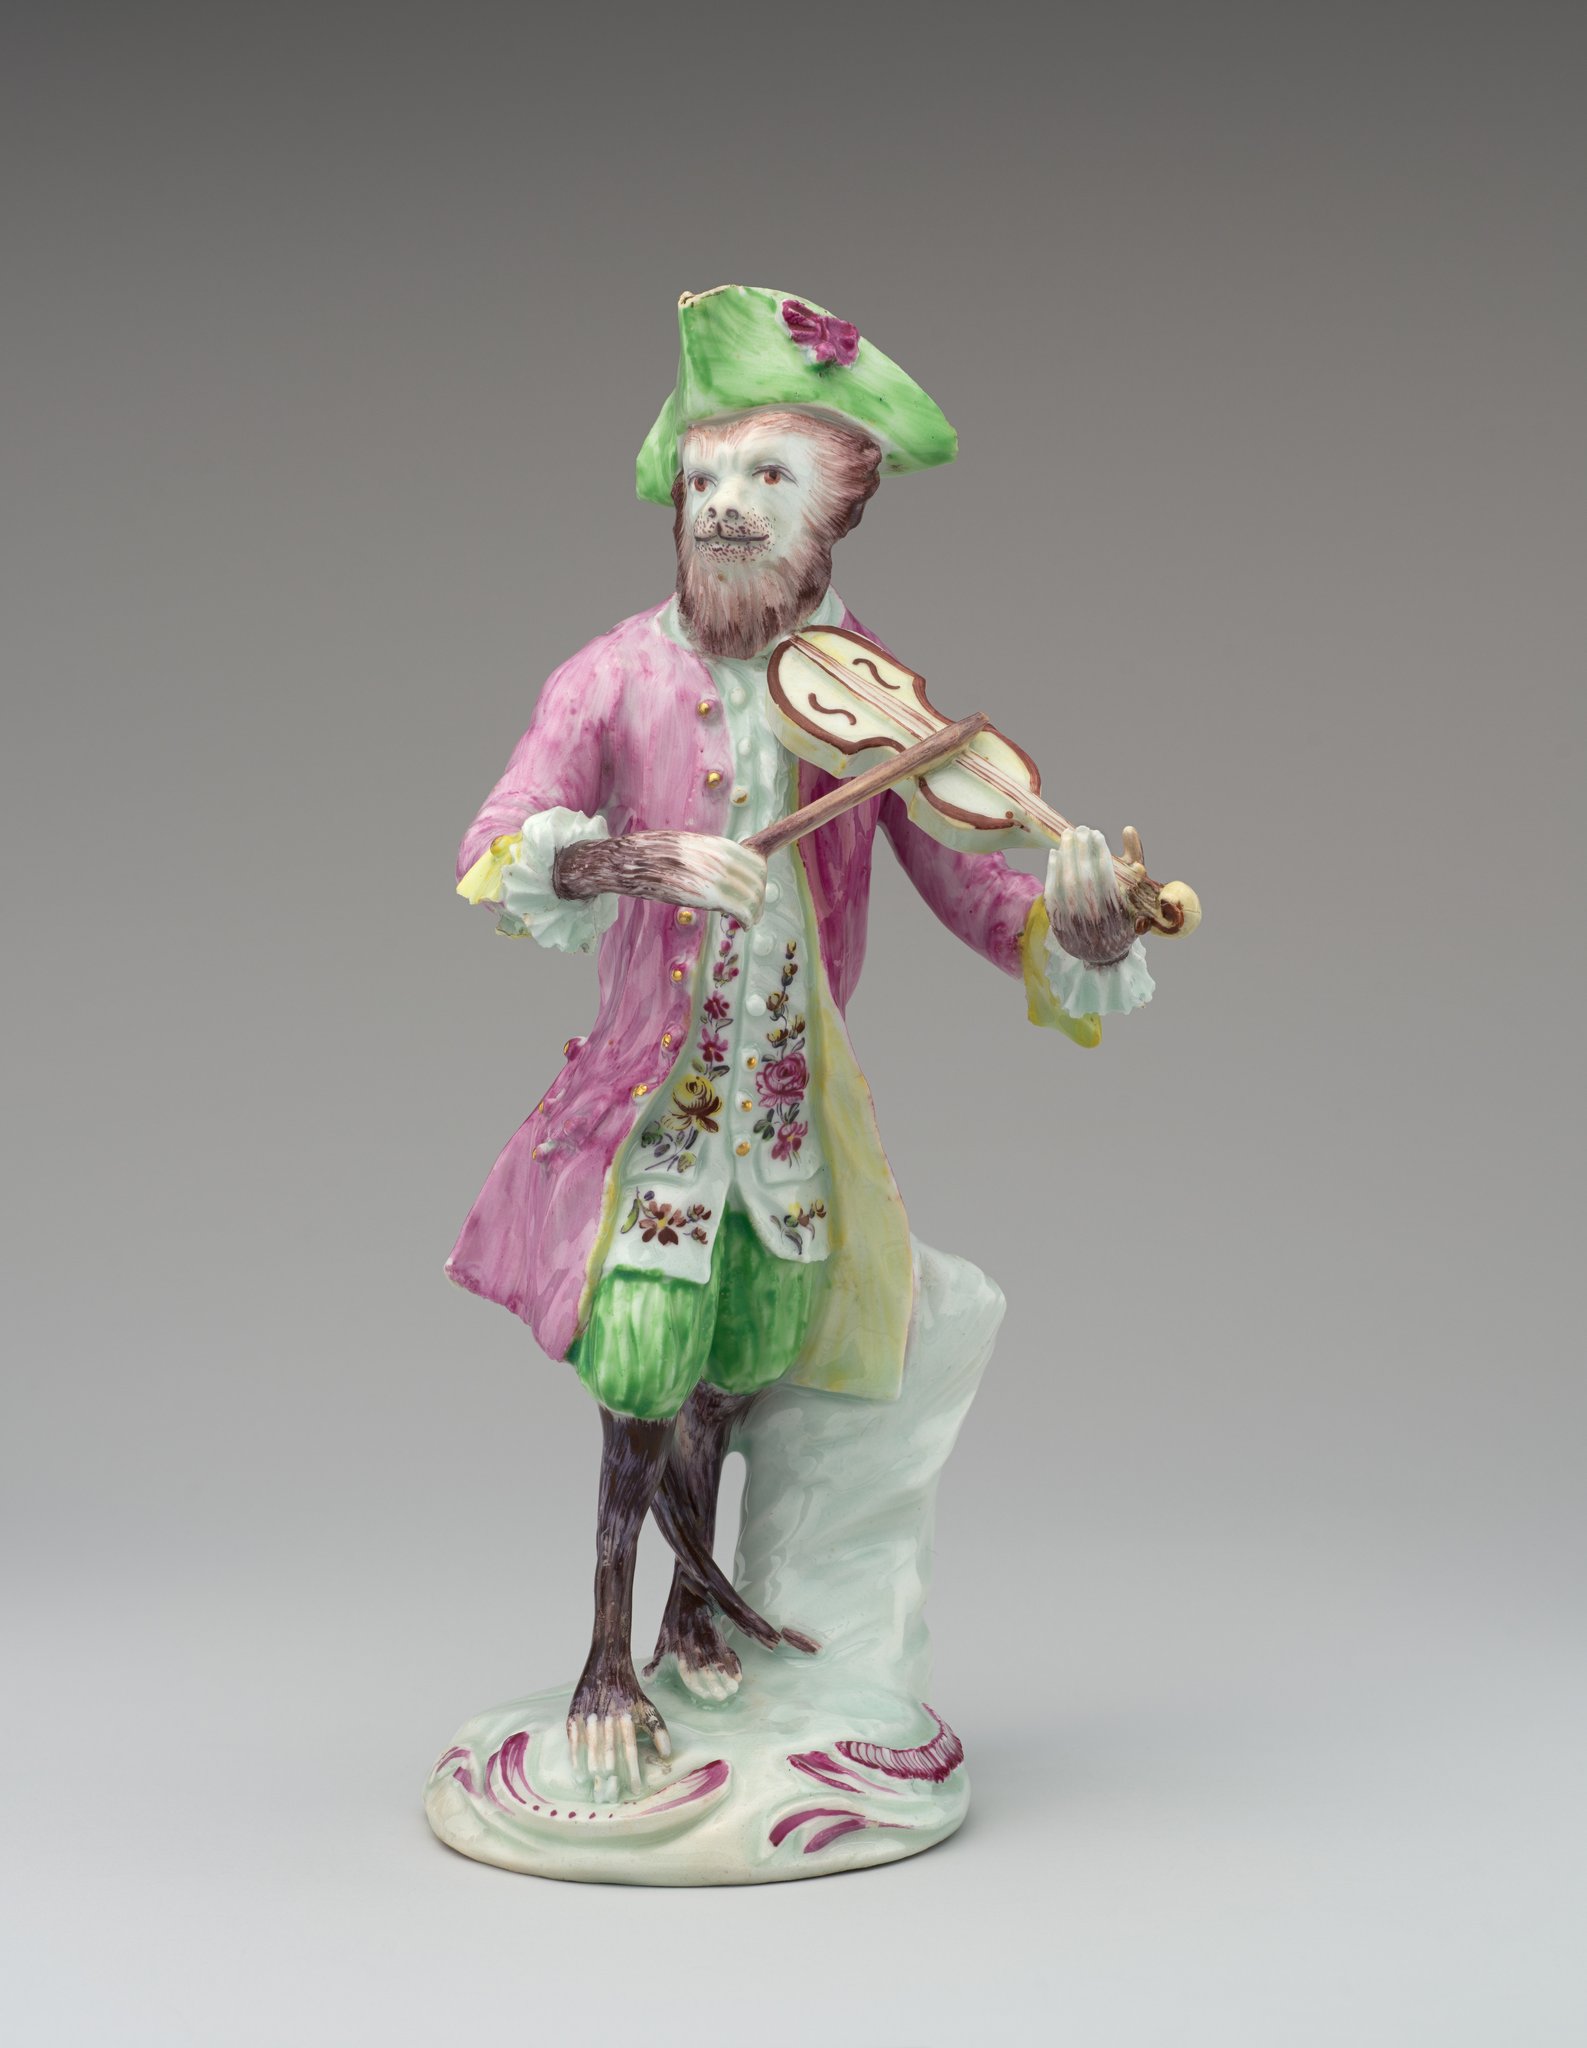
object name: figure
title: Monkey musician (part of a set)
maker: derby porcelain manufactory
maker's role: factory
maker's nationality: british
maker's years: 1751-1785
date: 1760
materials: soft paste porcelain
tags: violins,monkeys,musicians